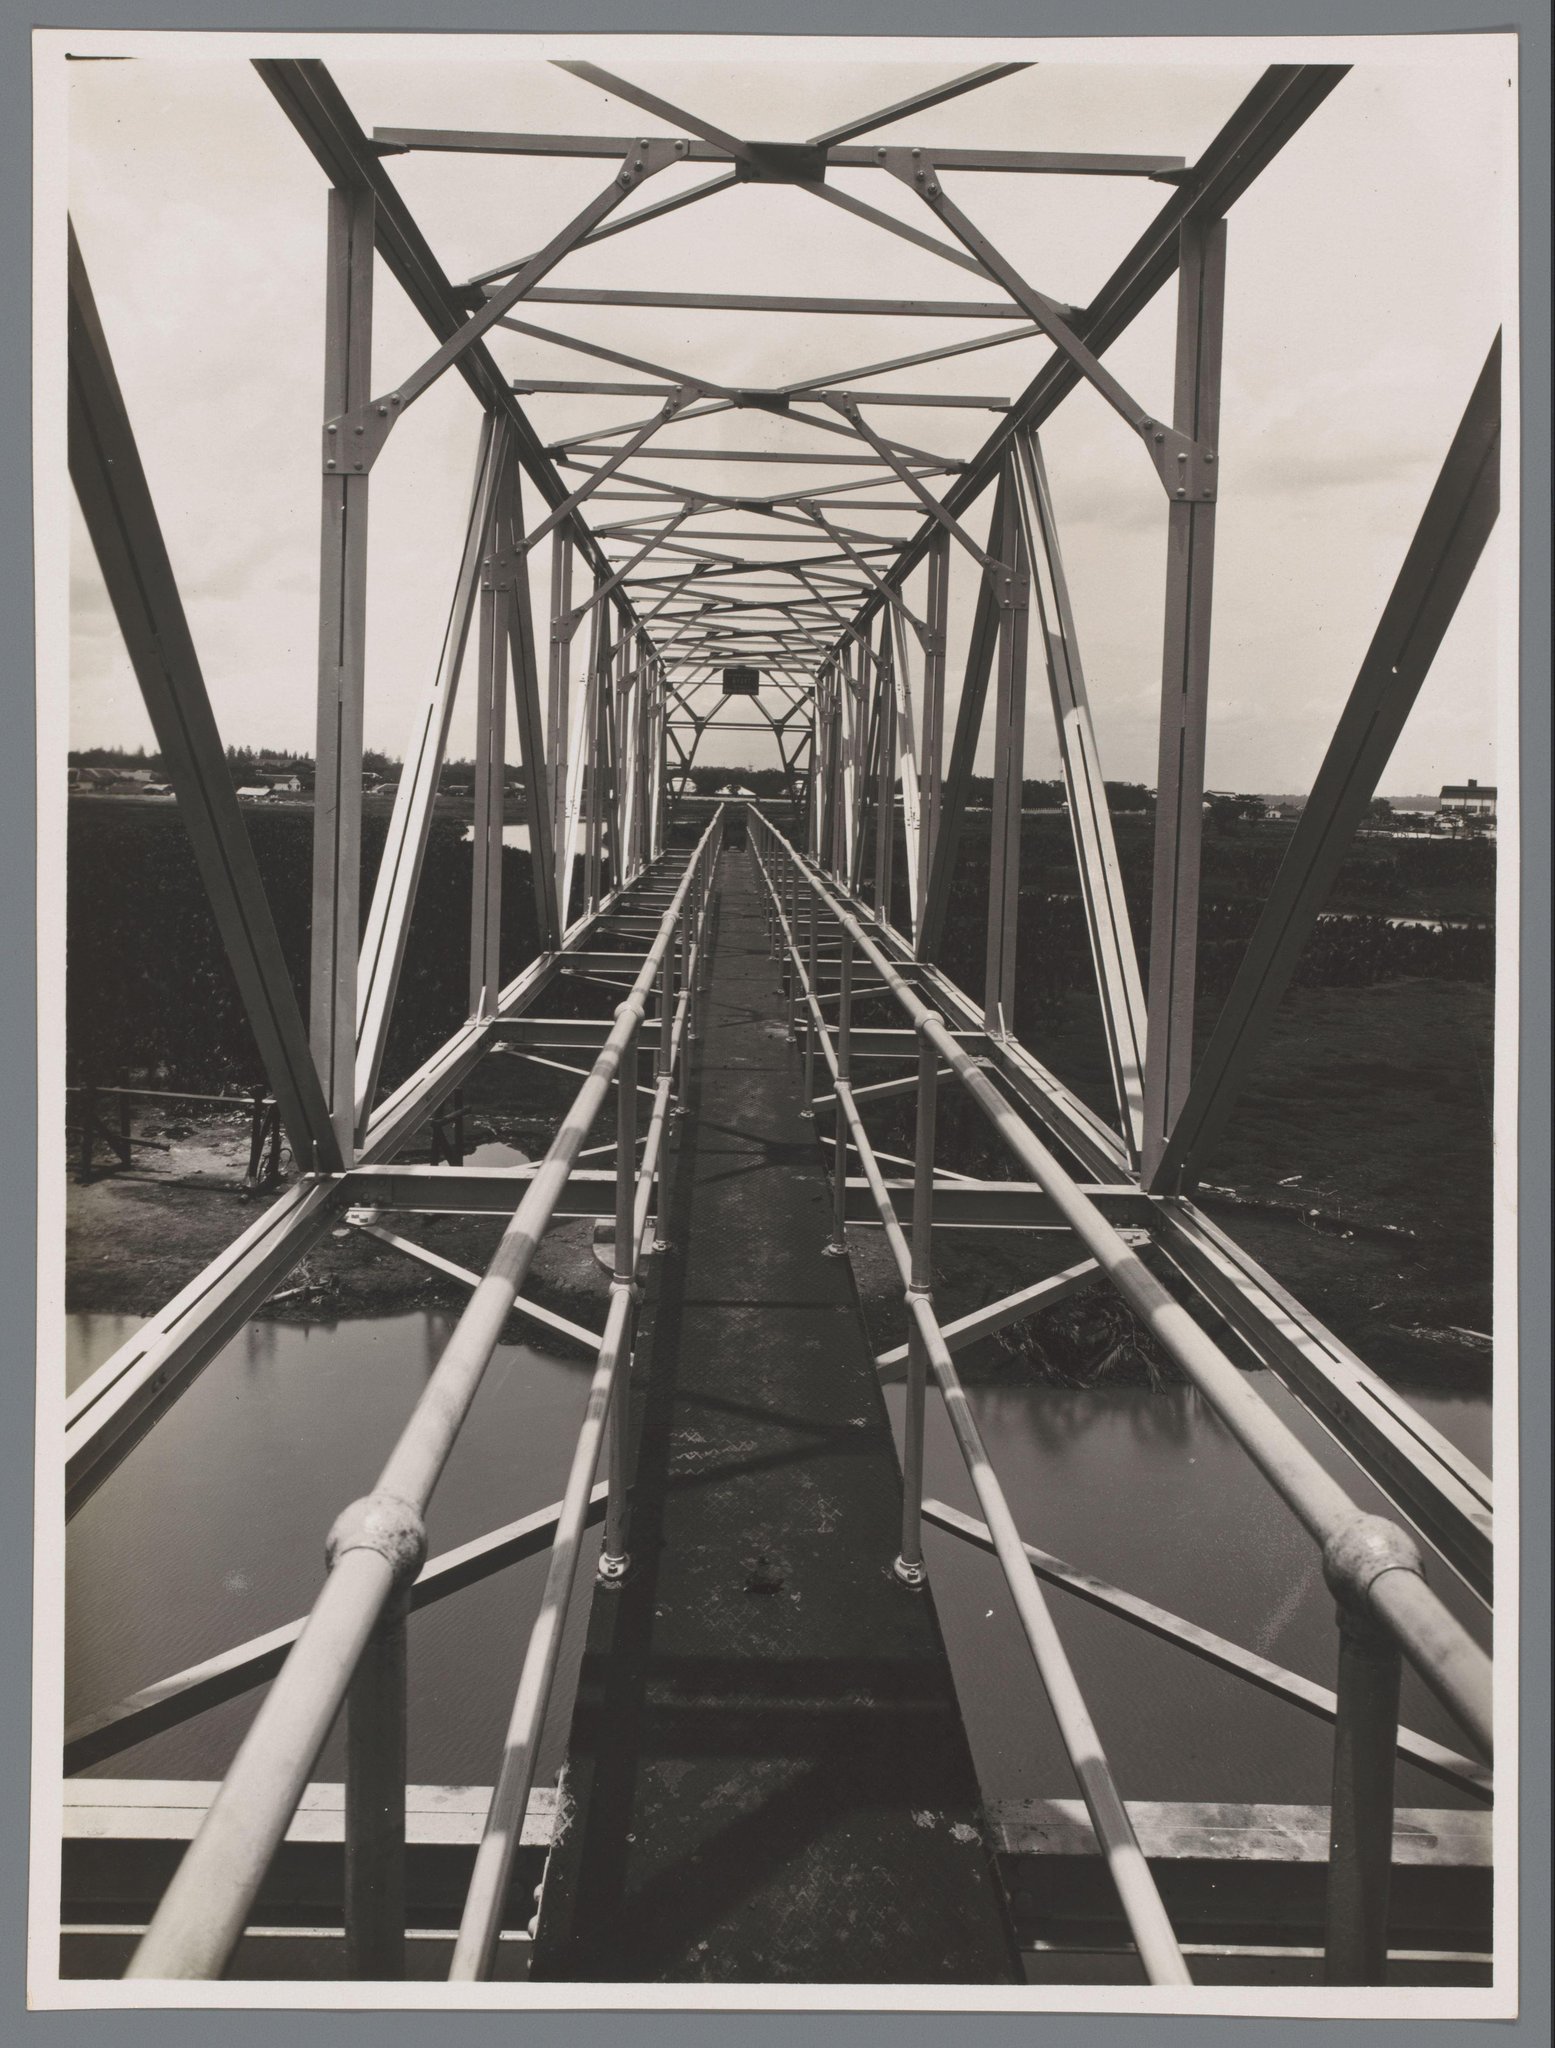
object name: photograph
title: Voetgangersbrug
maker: Anonymous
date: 1931-1940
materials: photographic support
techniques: gelatin silver print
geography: dutch east indies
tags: colonial system, bridge, java, dutch east indies, the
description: Een voetgangersbrug. Onderdeel van de multomap met foto's van bruggen gebouwd door de N.V. Machinefabriek Braat te Soerabaja en bestemd voor verschillende plaatsen in Nederlands-Indië, uit de periode 1931-1940.